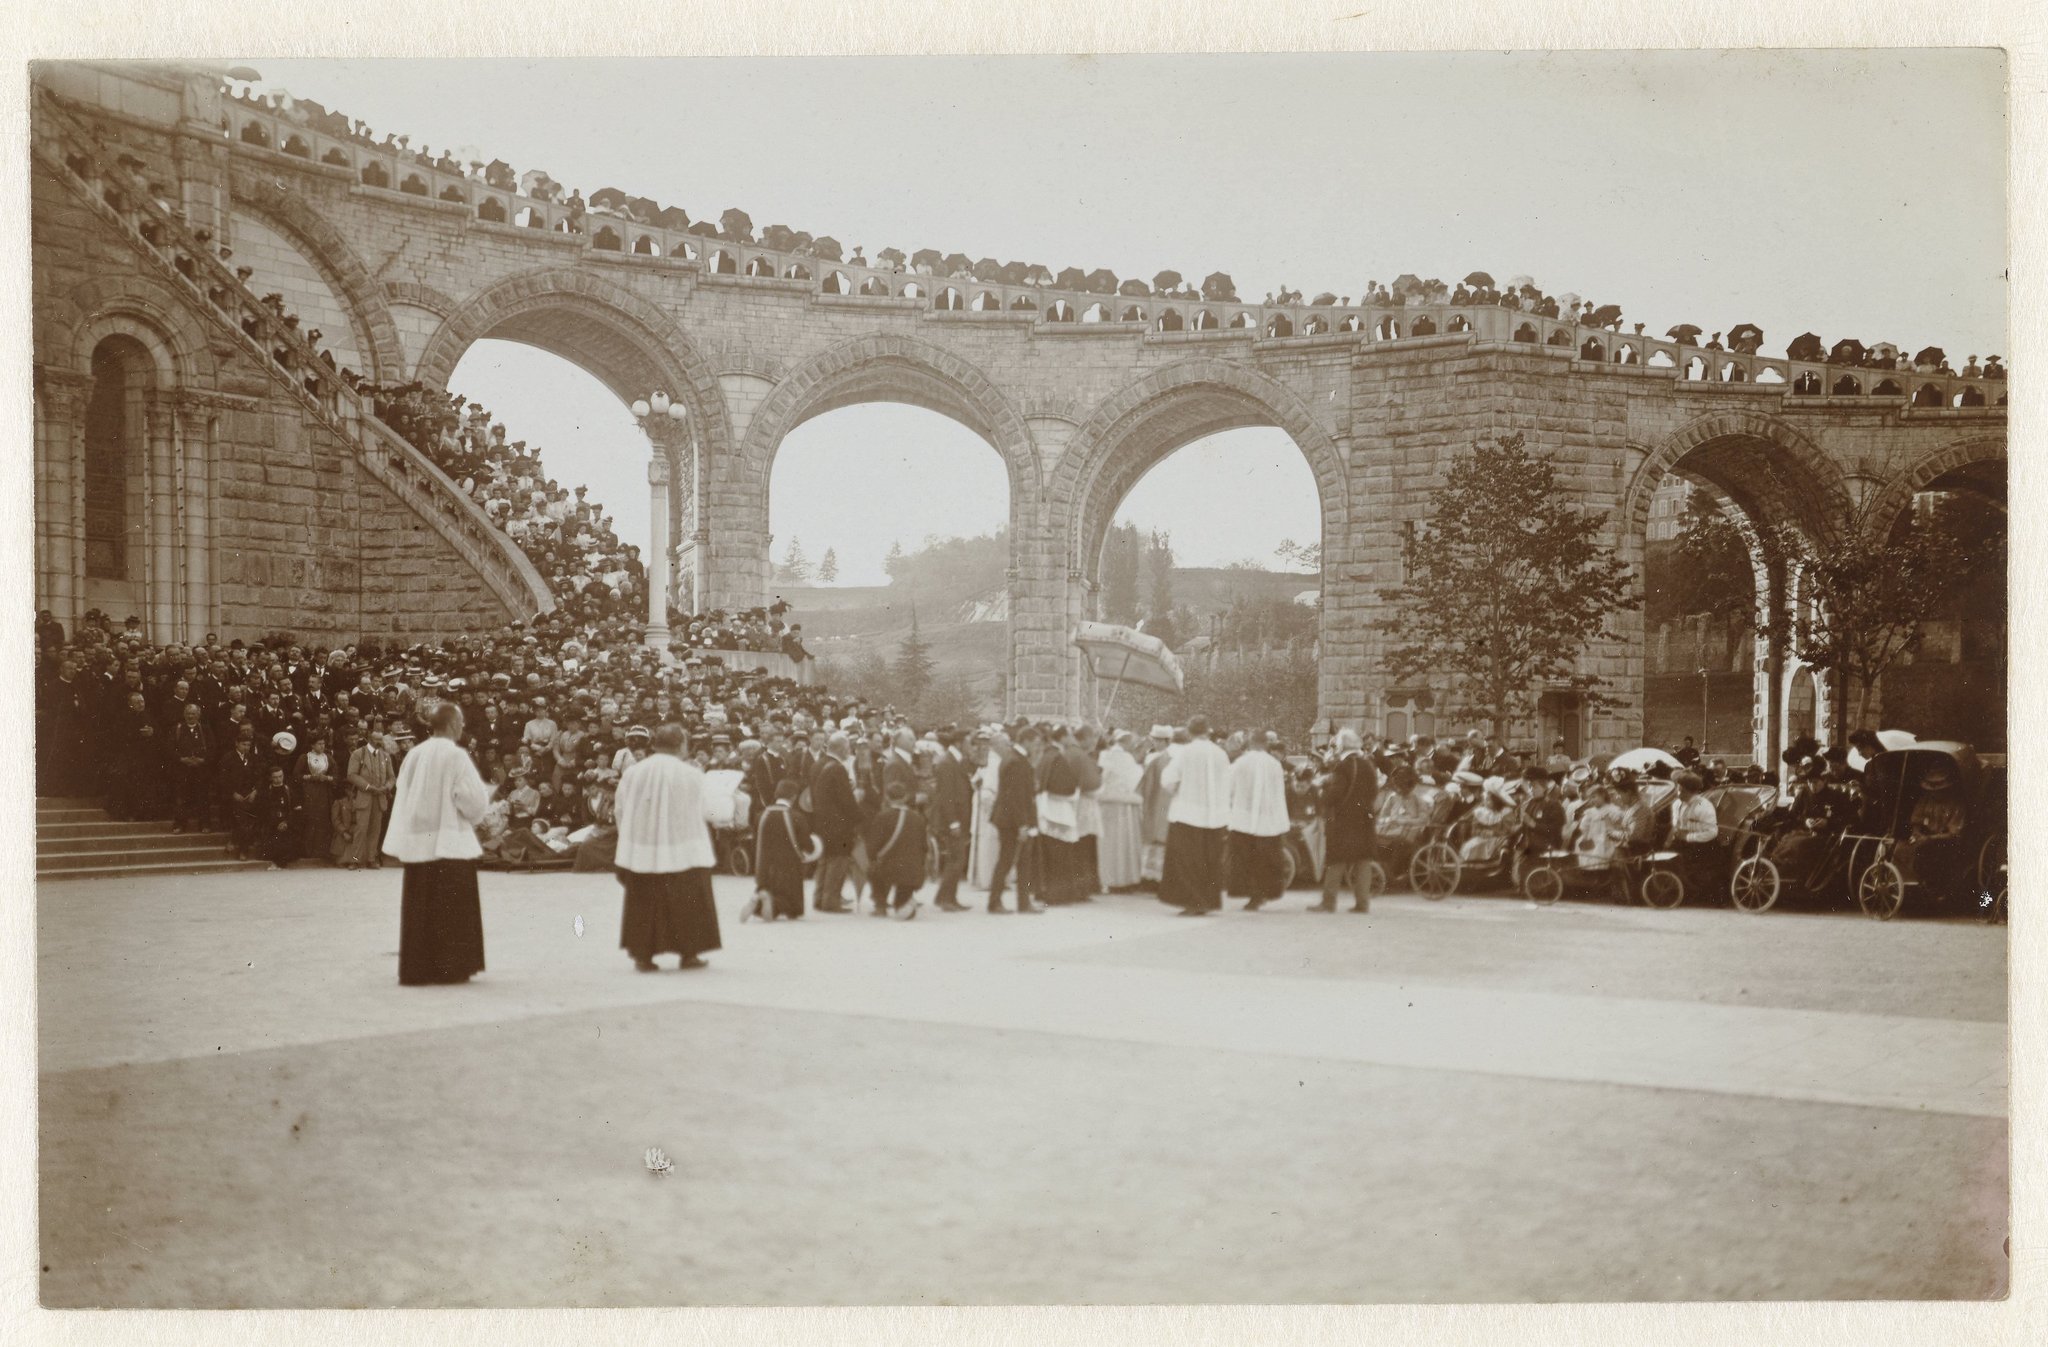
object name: photograph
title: Heilige mis voor de Rozenkransbasiliek in Lourdes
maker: Anonymous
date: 1880-1910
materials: paper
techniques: collodion silver print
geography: lourdes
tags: holy mass (divine service, especially of roman catholic church)